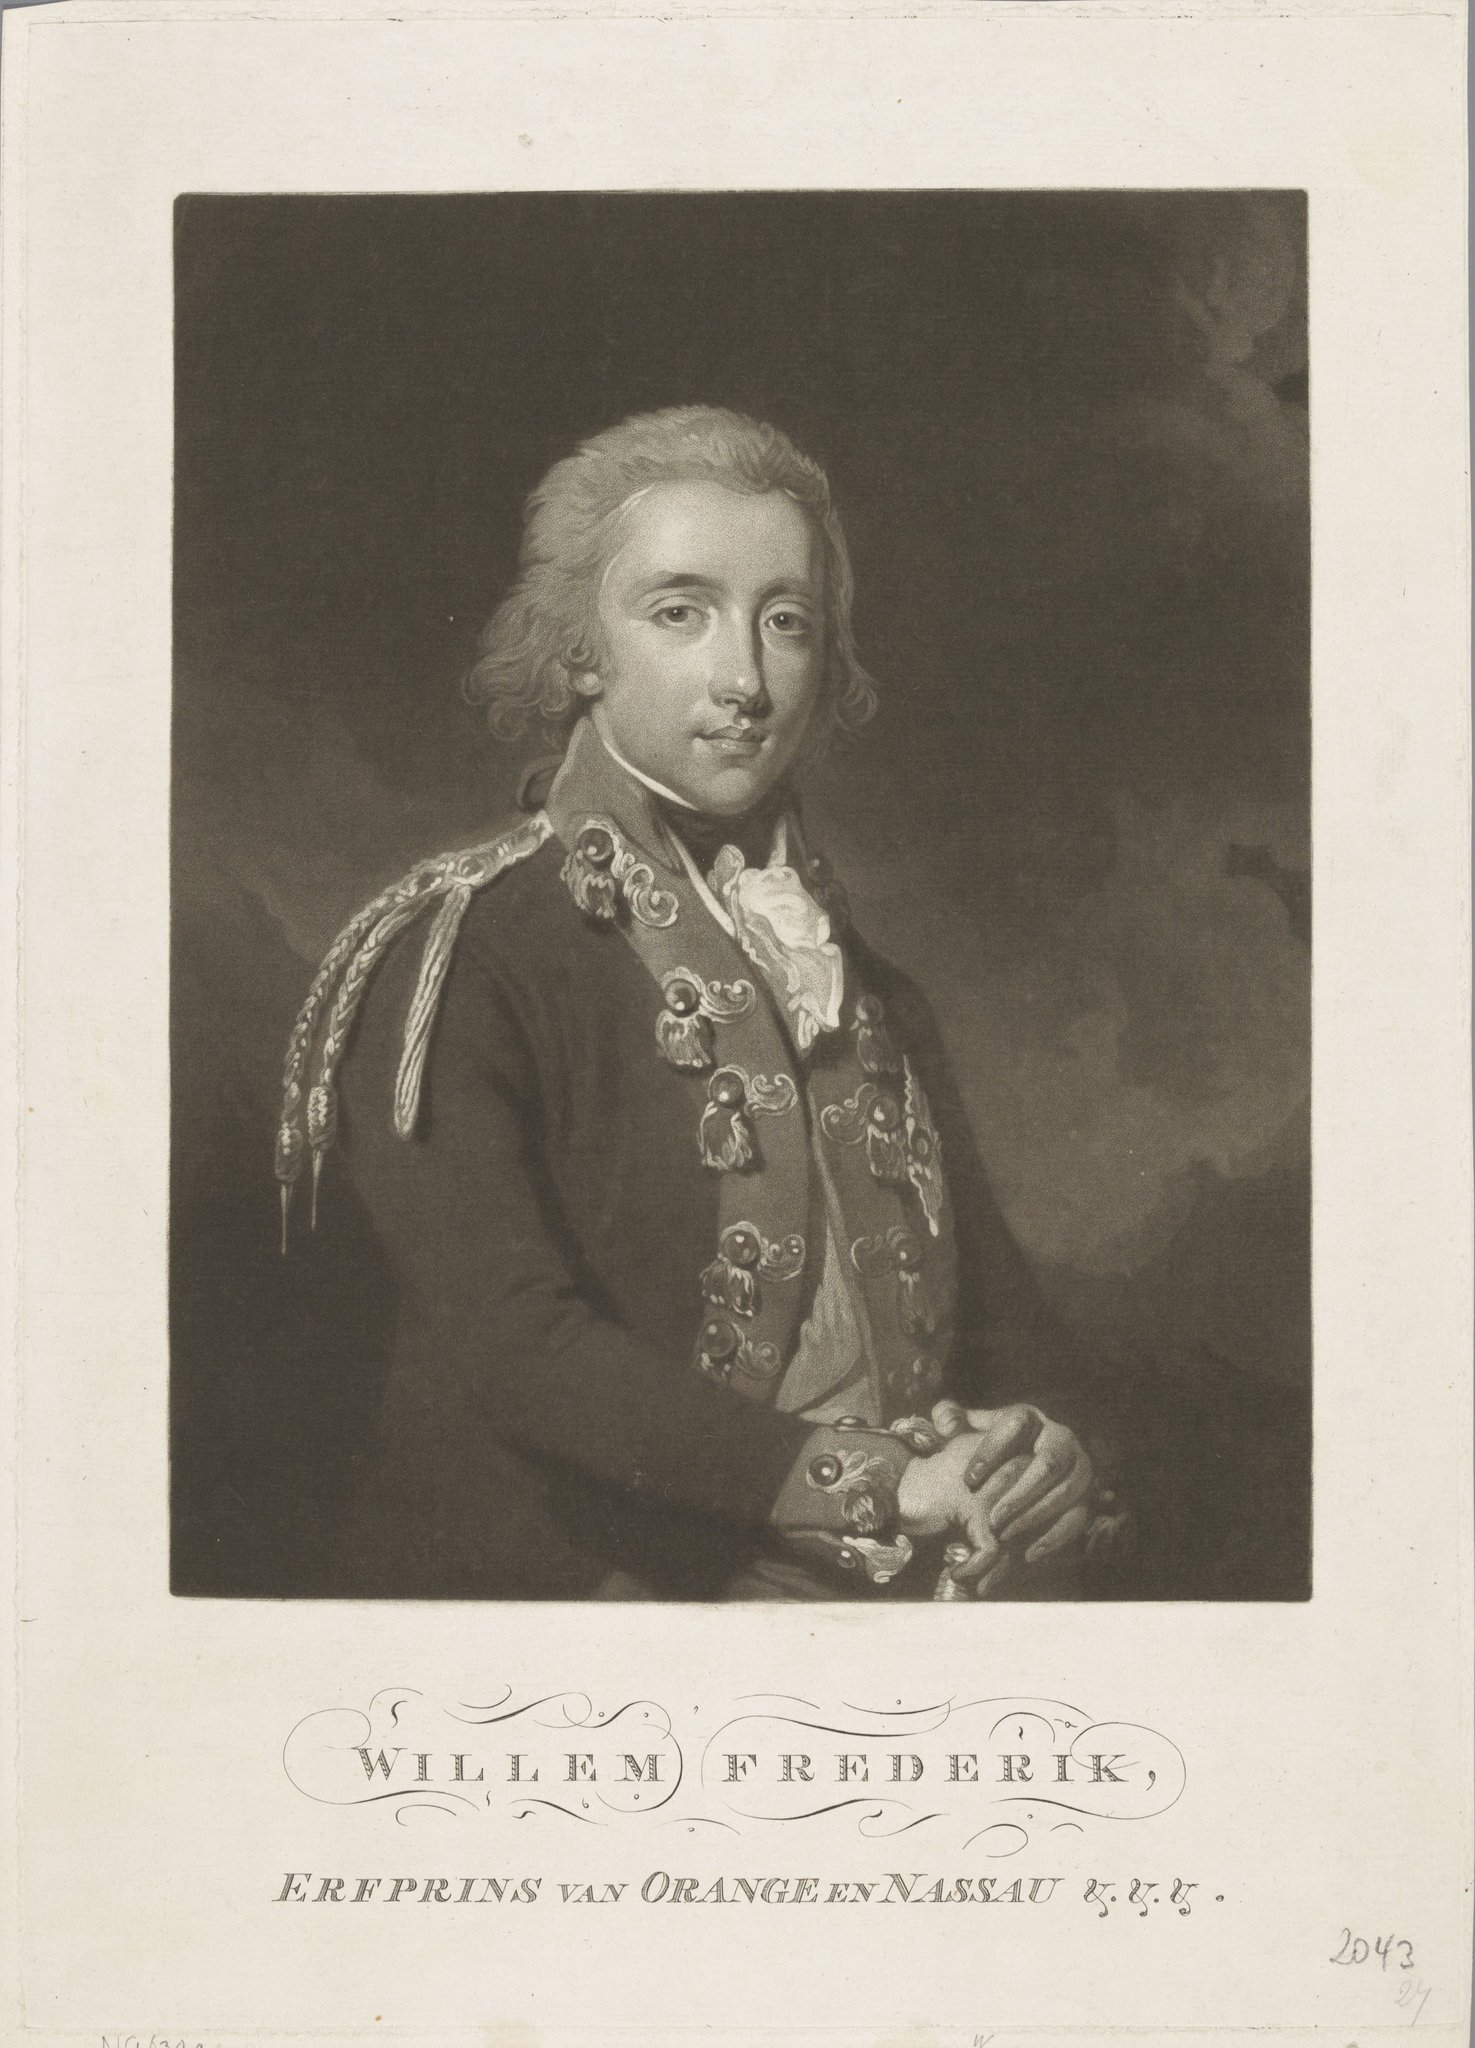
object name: print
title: Portret van Frederik, prins van Oranje-Nassau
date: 1790-1837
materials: paper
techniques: mezzotint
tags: the hague, willem george frederik (prins van oranje-nassau)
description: De hier vermelde titel verwijst naar de hoogst verkregen titel van de geportretteerde, niet per se naar de titel die de geportretteerde op deze voorstelling draagt.